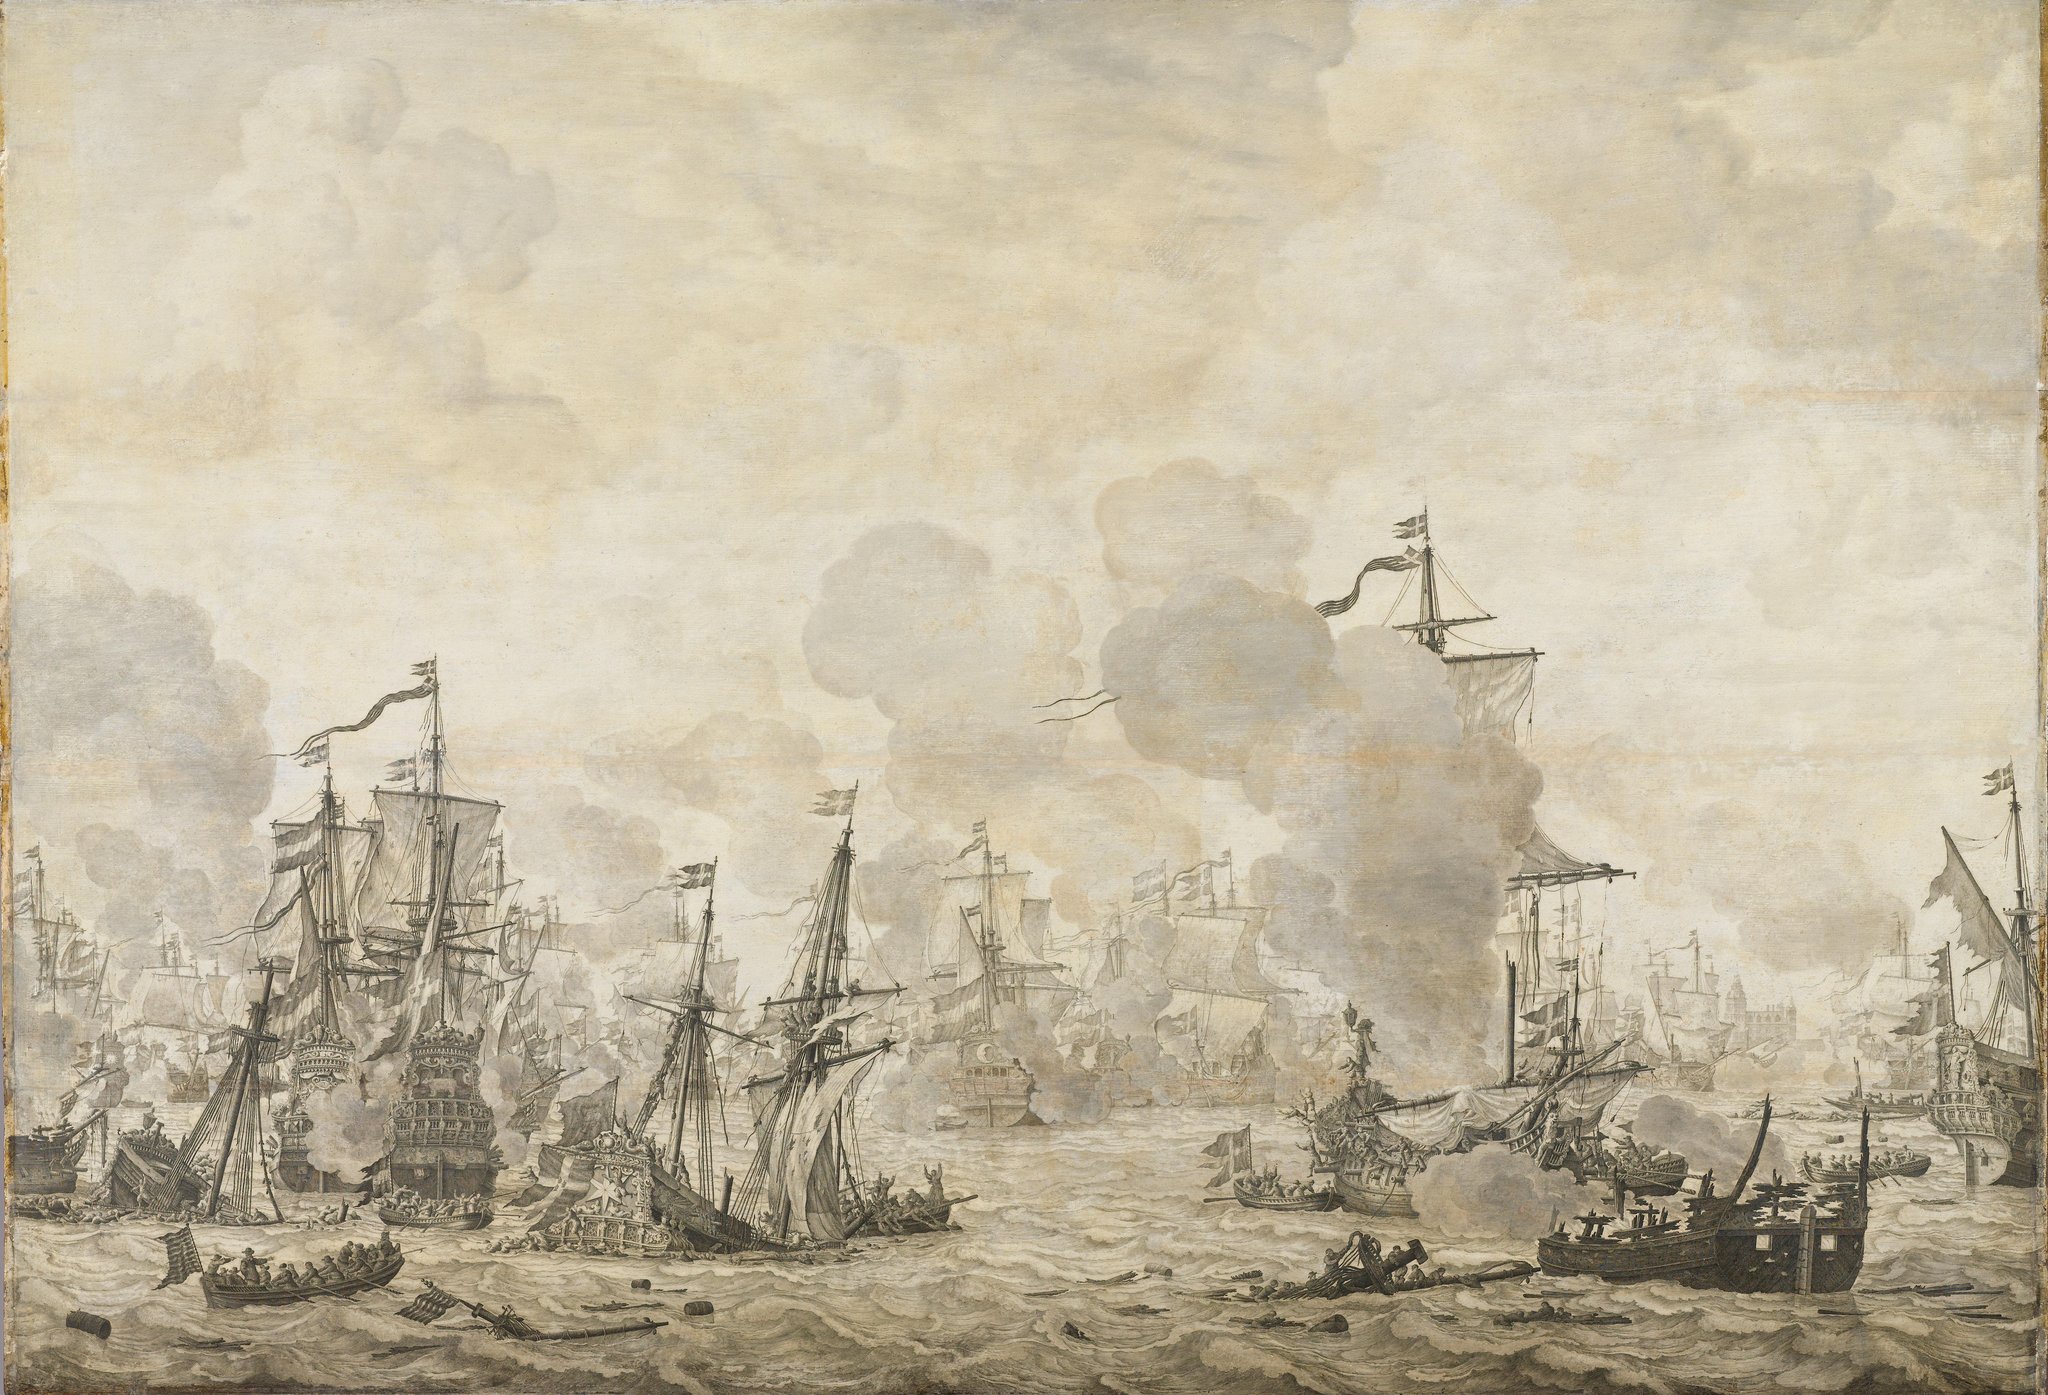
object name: penschildering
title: Episode from the Battle between the Dutch and Swedish Fleets in the Sound, 8 November 1658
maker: willem van de velde (i)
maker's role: draughtsman, painter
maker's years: 1611-1693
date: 1658-1693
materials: ink, panel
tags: sailing-ship, sailing-boat, navy, battle (+ sailing-ships)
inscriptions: signature: ‘W. v. Velde’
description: Episode uit de slag in het Sont tussen de Hollandse en Zweedse vloot, 8 november 1658. Links op de voorgrond een zinkend Zweeds schip, rechts een brander en een brandend Zweeds oorlogsschip.